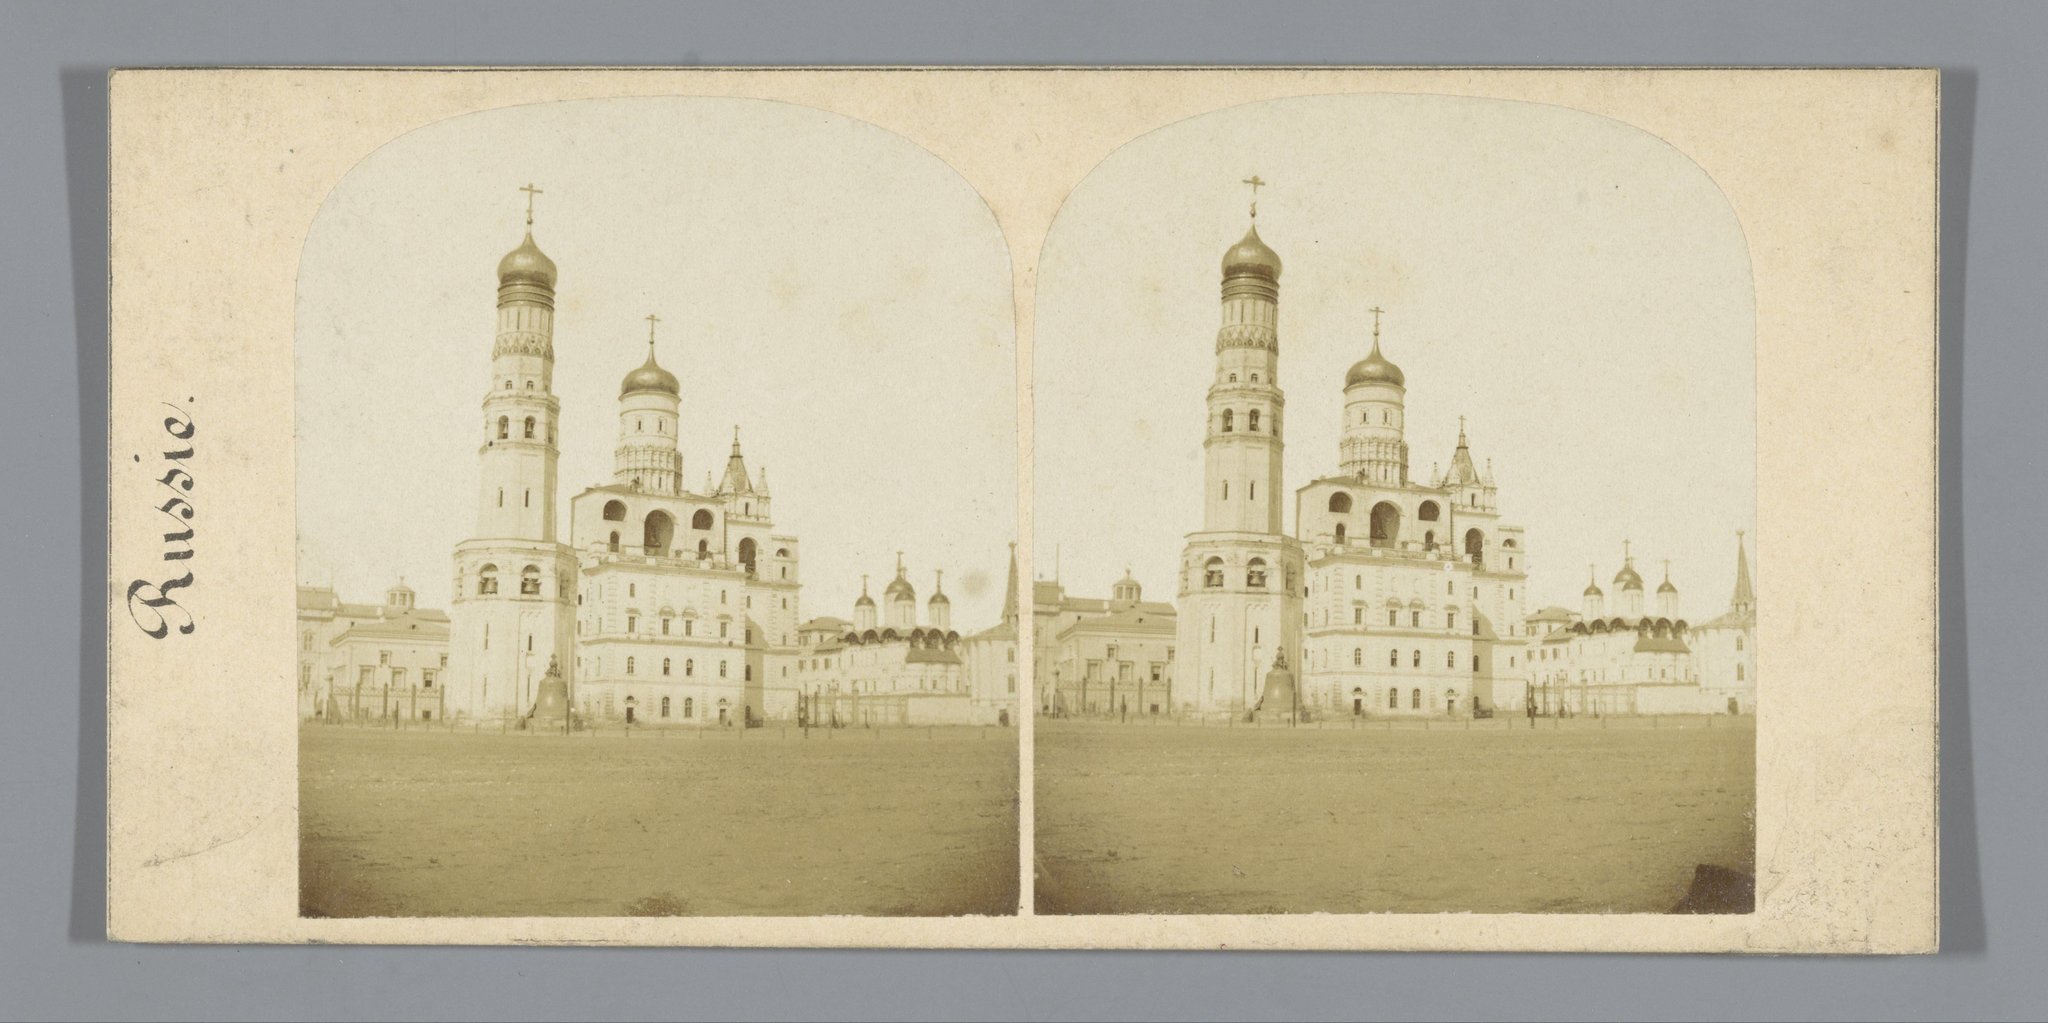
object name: stereograph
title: Gezicht op de klokkentoren van Ivan de Grote in het Kremlin te Moskou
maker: Anonymous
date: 1850-1880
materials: cardboard, photographic support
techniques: albumen print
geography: moscow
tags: tower, clock tower ~ monumental adornment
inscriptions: inscription: ‘Russie.’, inscription: ‘No 62. Le grand clocher d'Ivan, au Kremlin Moscou’